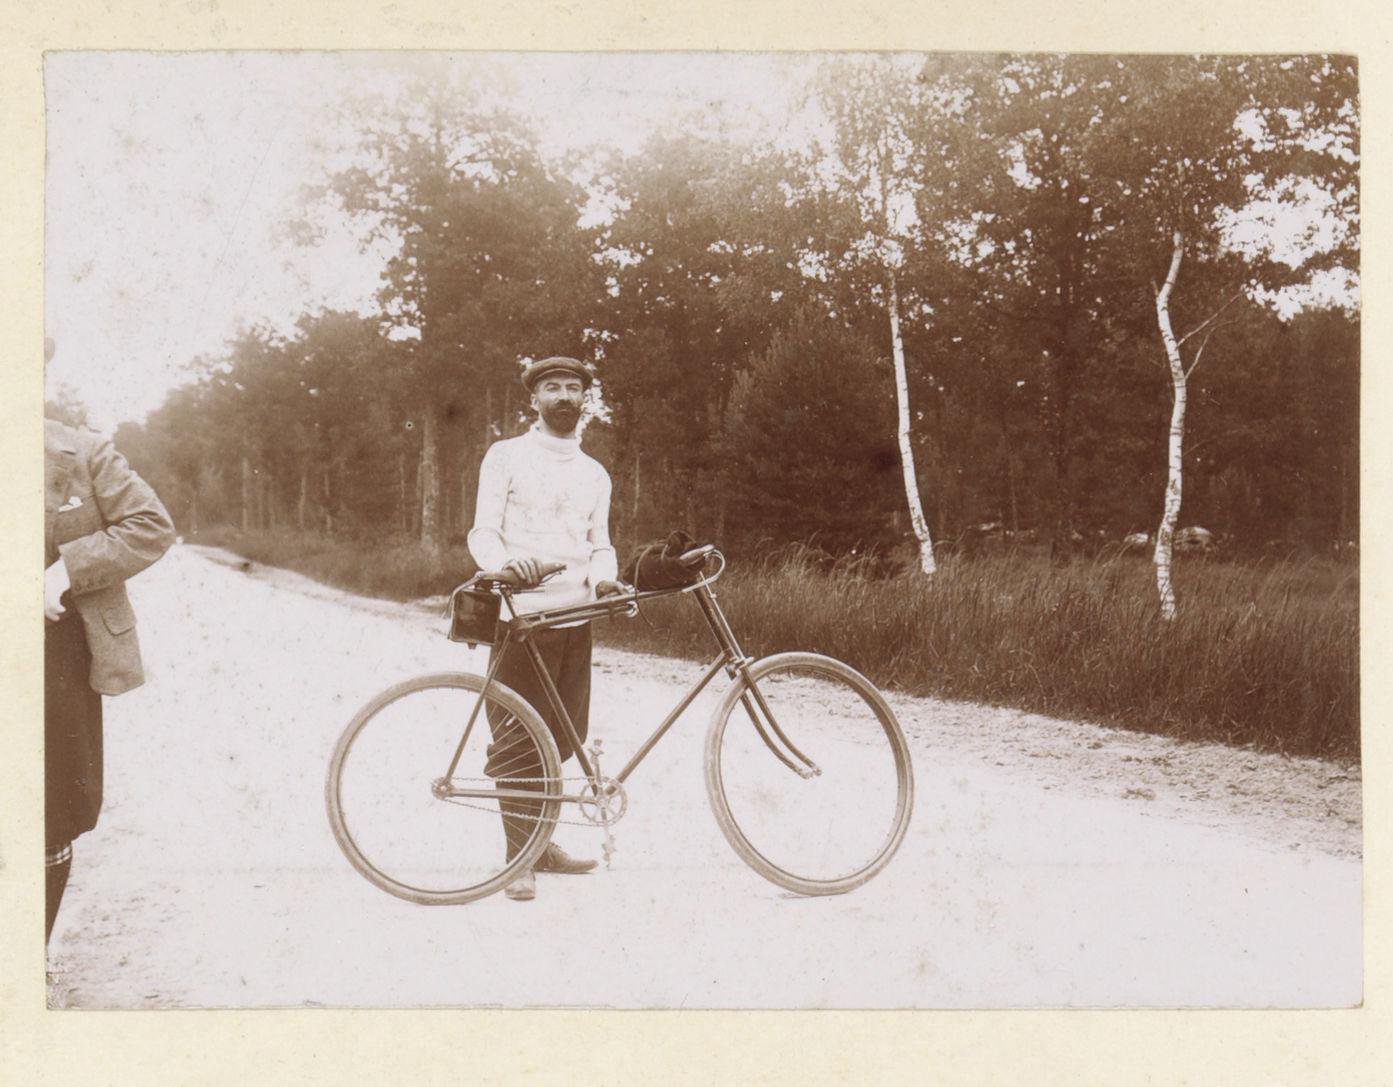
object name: photograph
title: Man poseert met een fiets op een weg in Frankrijk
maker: Anonymous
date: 1900-1910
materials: paper, photographic support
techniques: daylight paper print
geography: france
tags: road, path, bicycle, france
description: Onderdeel van Fotoalbum van een Franse amateurfotograaf met opnames van een familie, distilleerderij Delizy & Doistau Fils, het leger en bezienswaardigheden in Frankrijk.